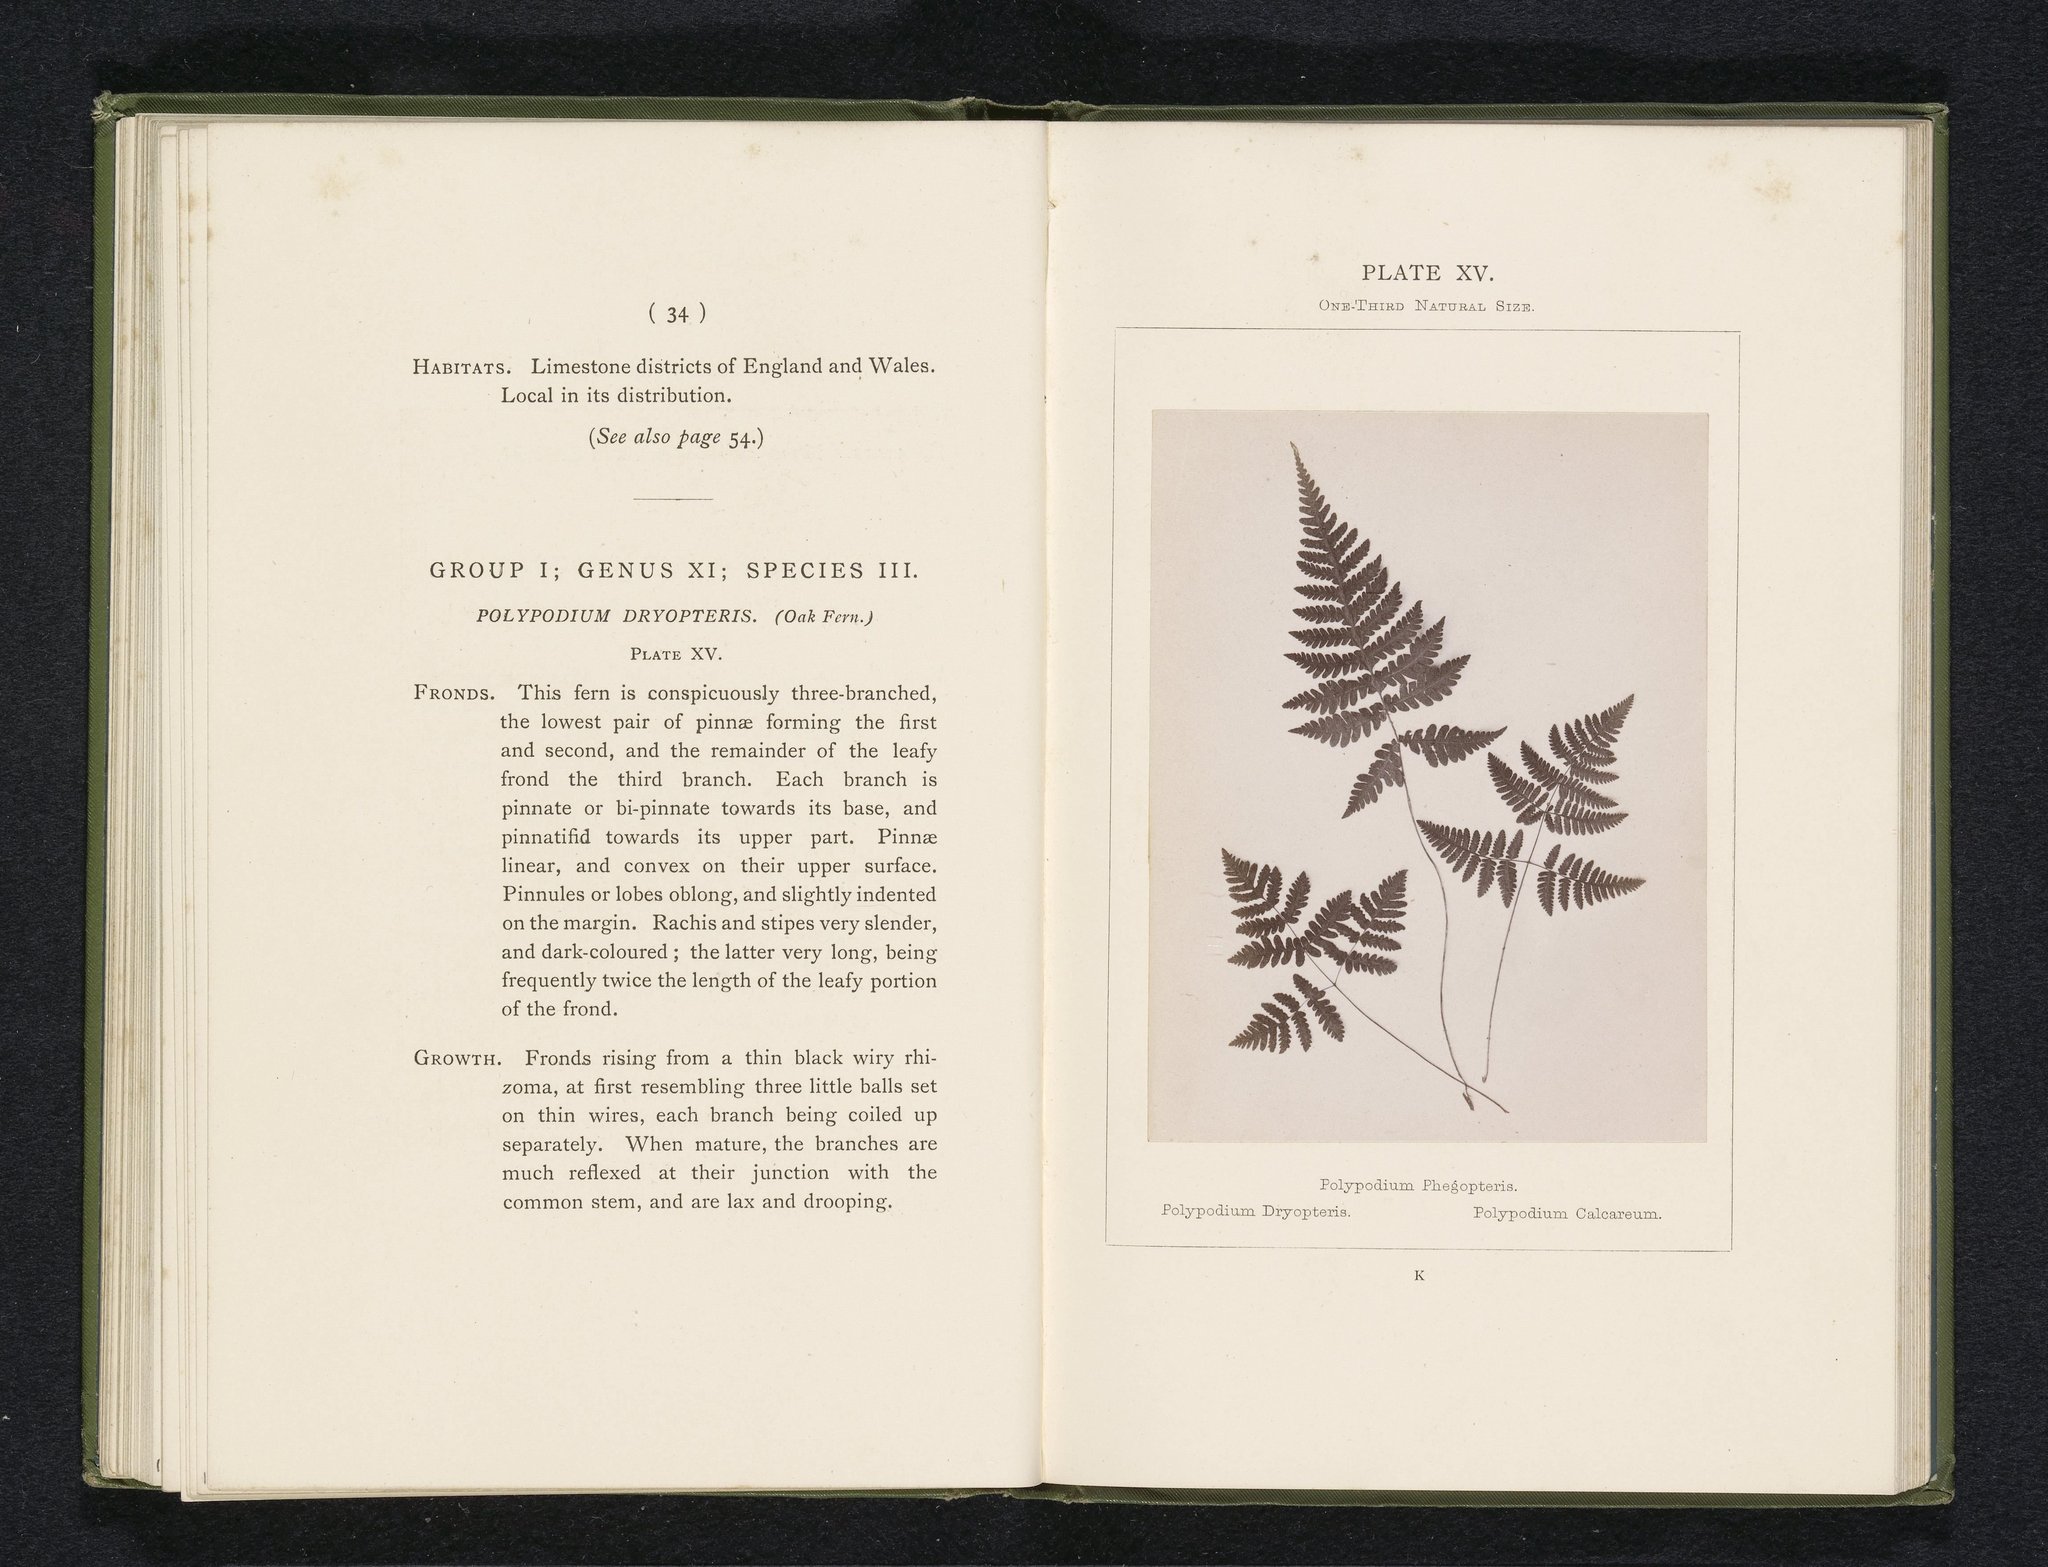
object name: photograph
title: Polypodium Phegopteris. Polypodium Dryopteris. Polypodium Calcareum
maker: sydney courtauld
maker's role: botanicus, fotograaf, schrijver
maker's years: 1840-1899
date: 1867-1877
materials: photographic support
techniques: albumen print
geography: england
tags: ferns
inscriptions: inscription: ‘Plate XV. One-third natural size.’